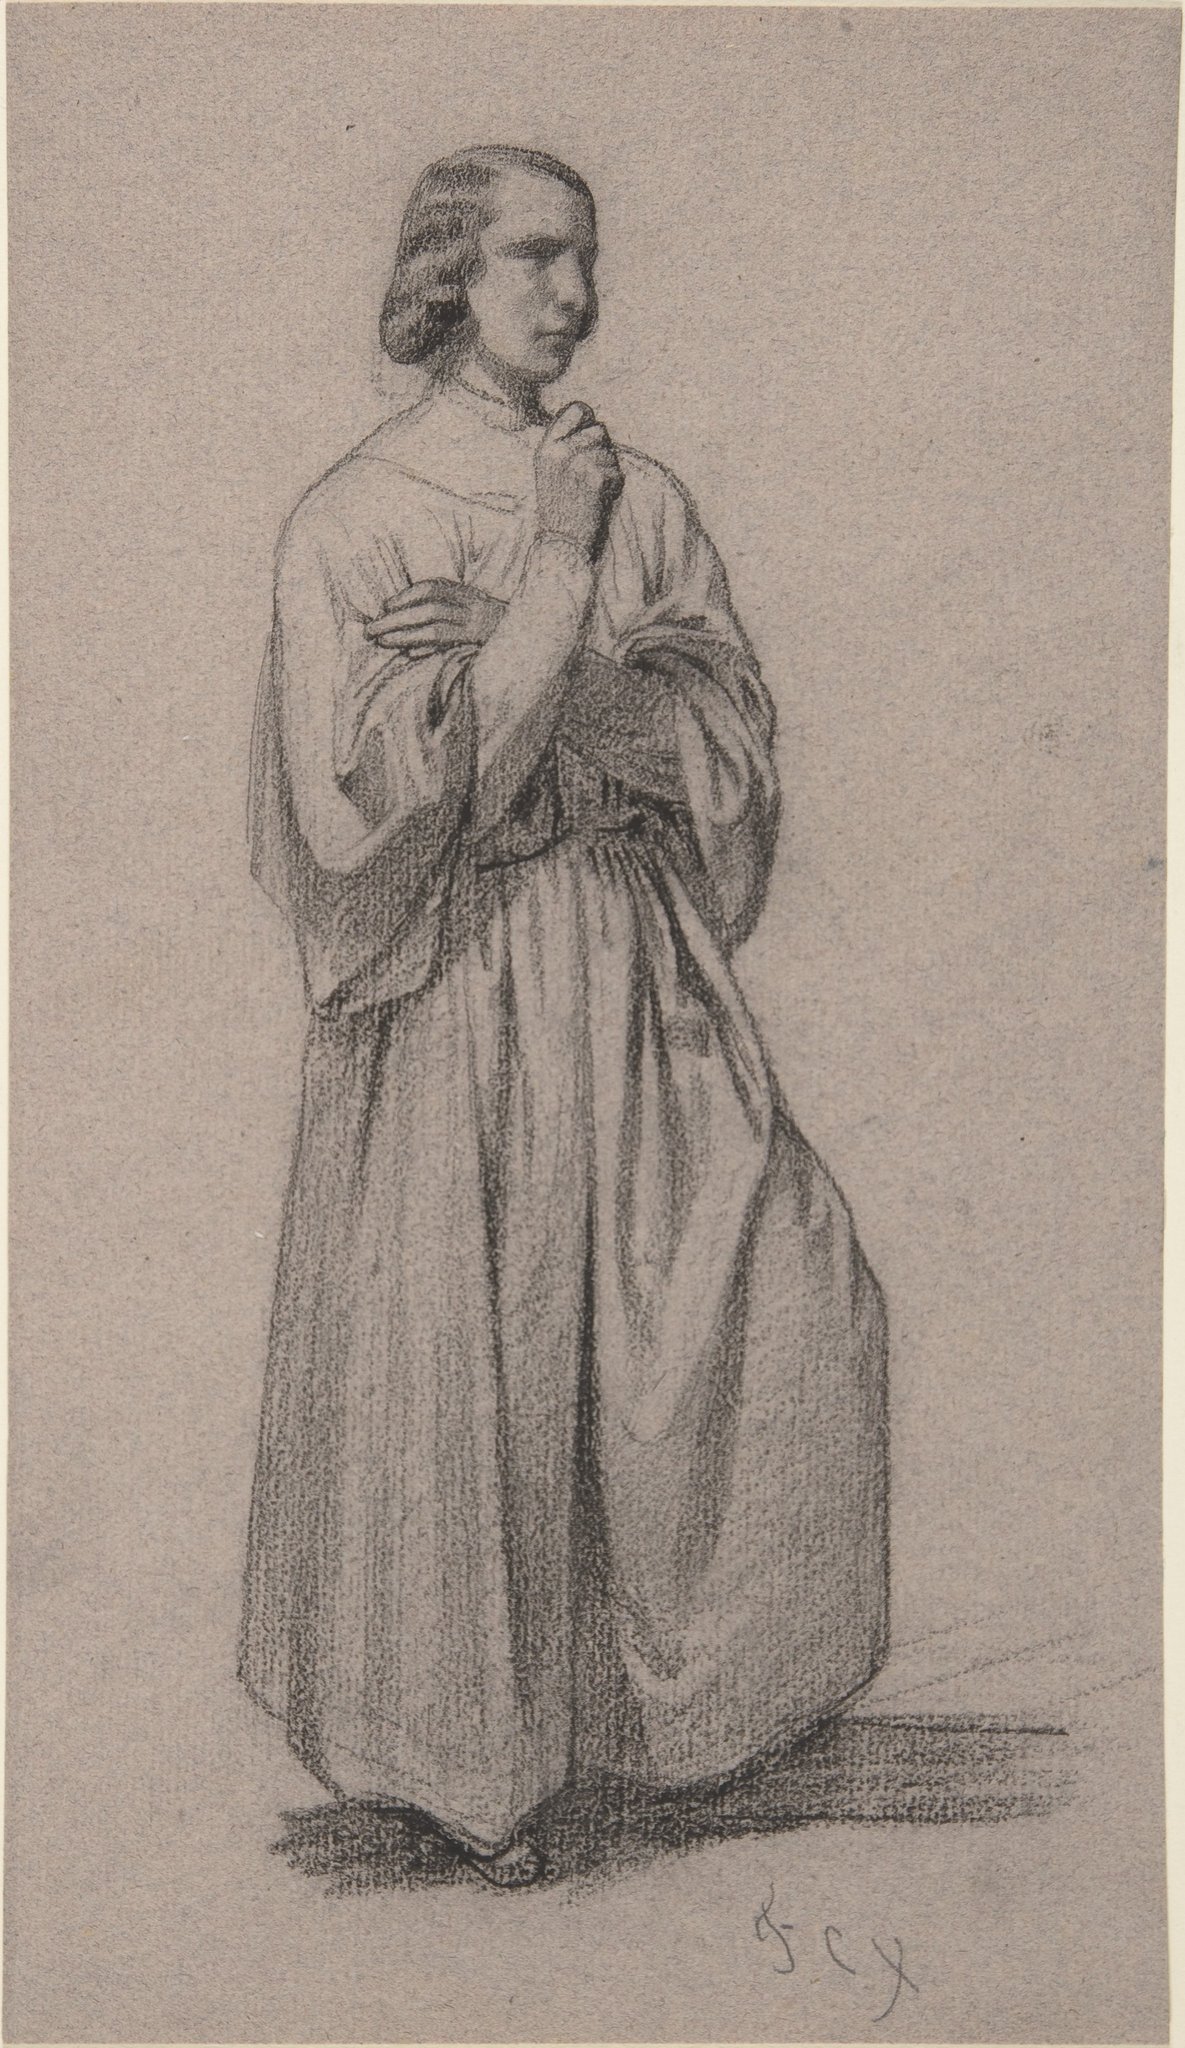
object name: drawing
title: Three-Quarter View of a Standing Male Robed Figure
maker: françois-claudius compte-calix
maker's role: artist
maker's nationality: french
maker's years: 1813-1880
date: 1813-1880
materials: charcoal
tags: men